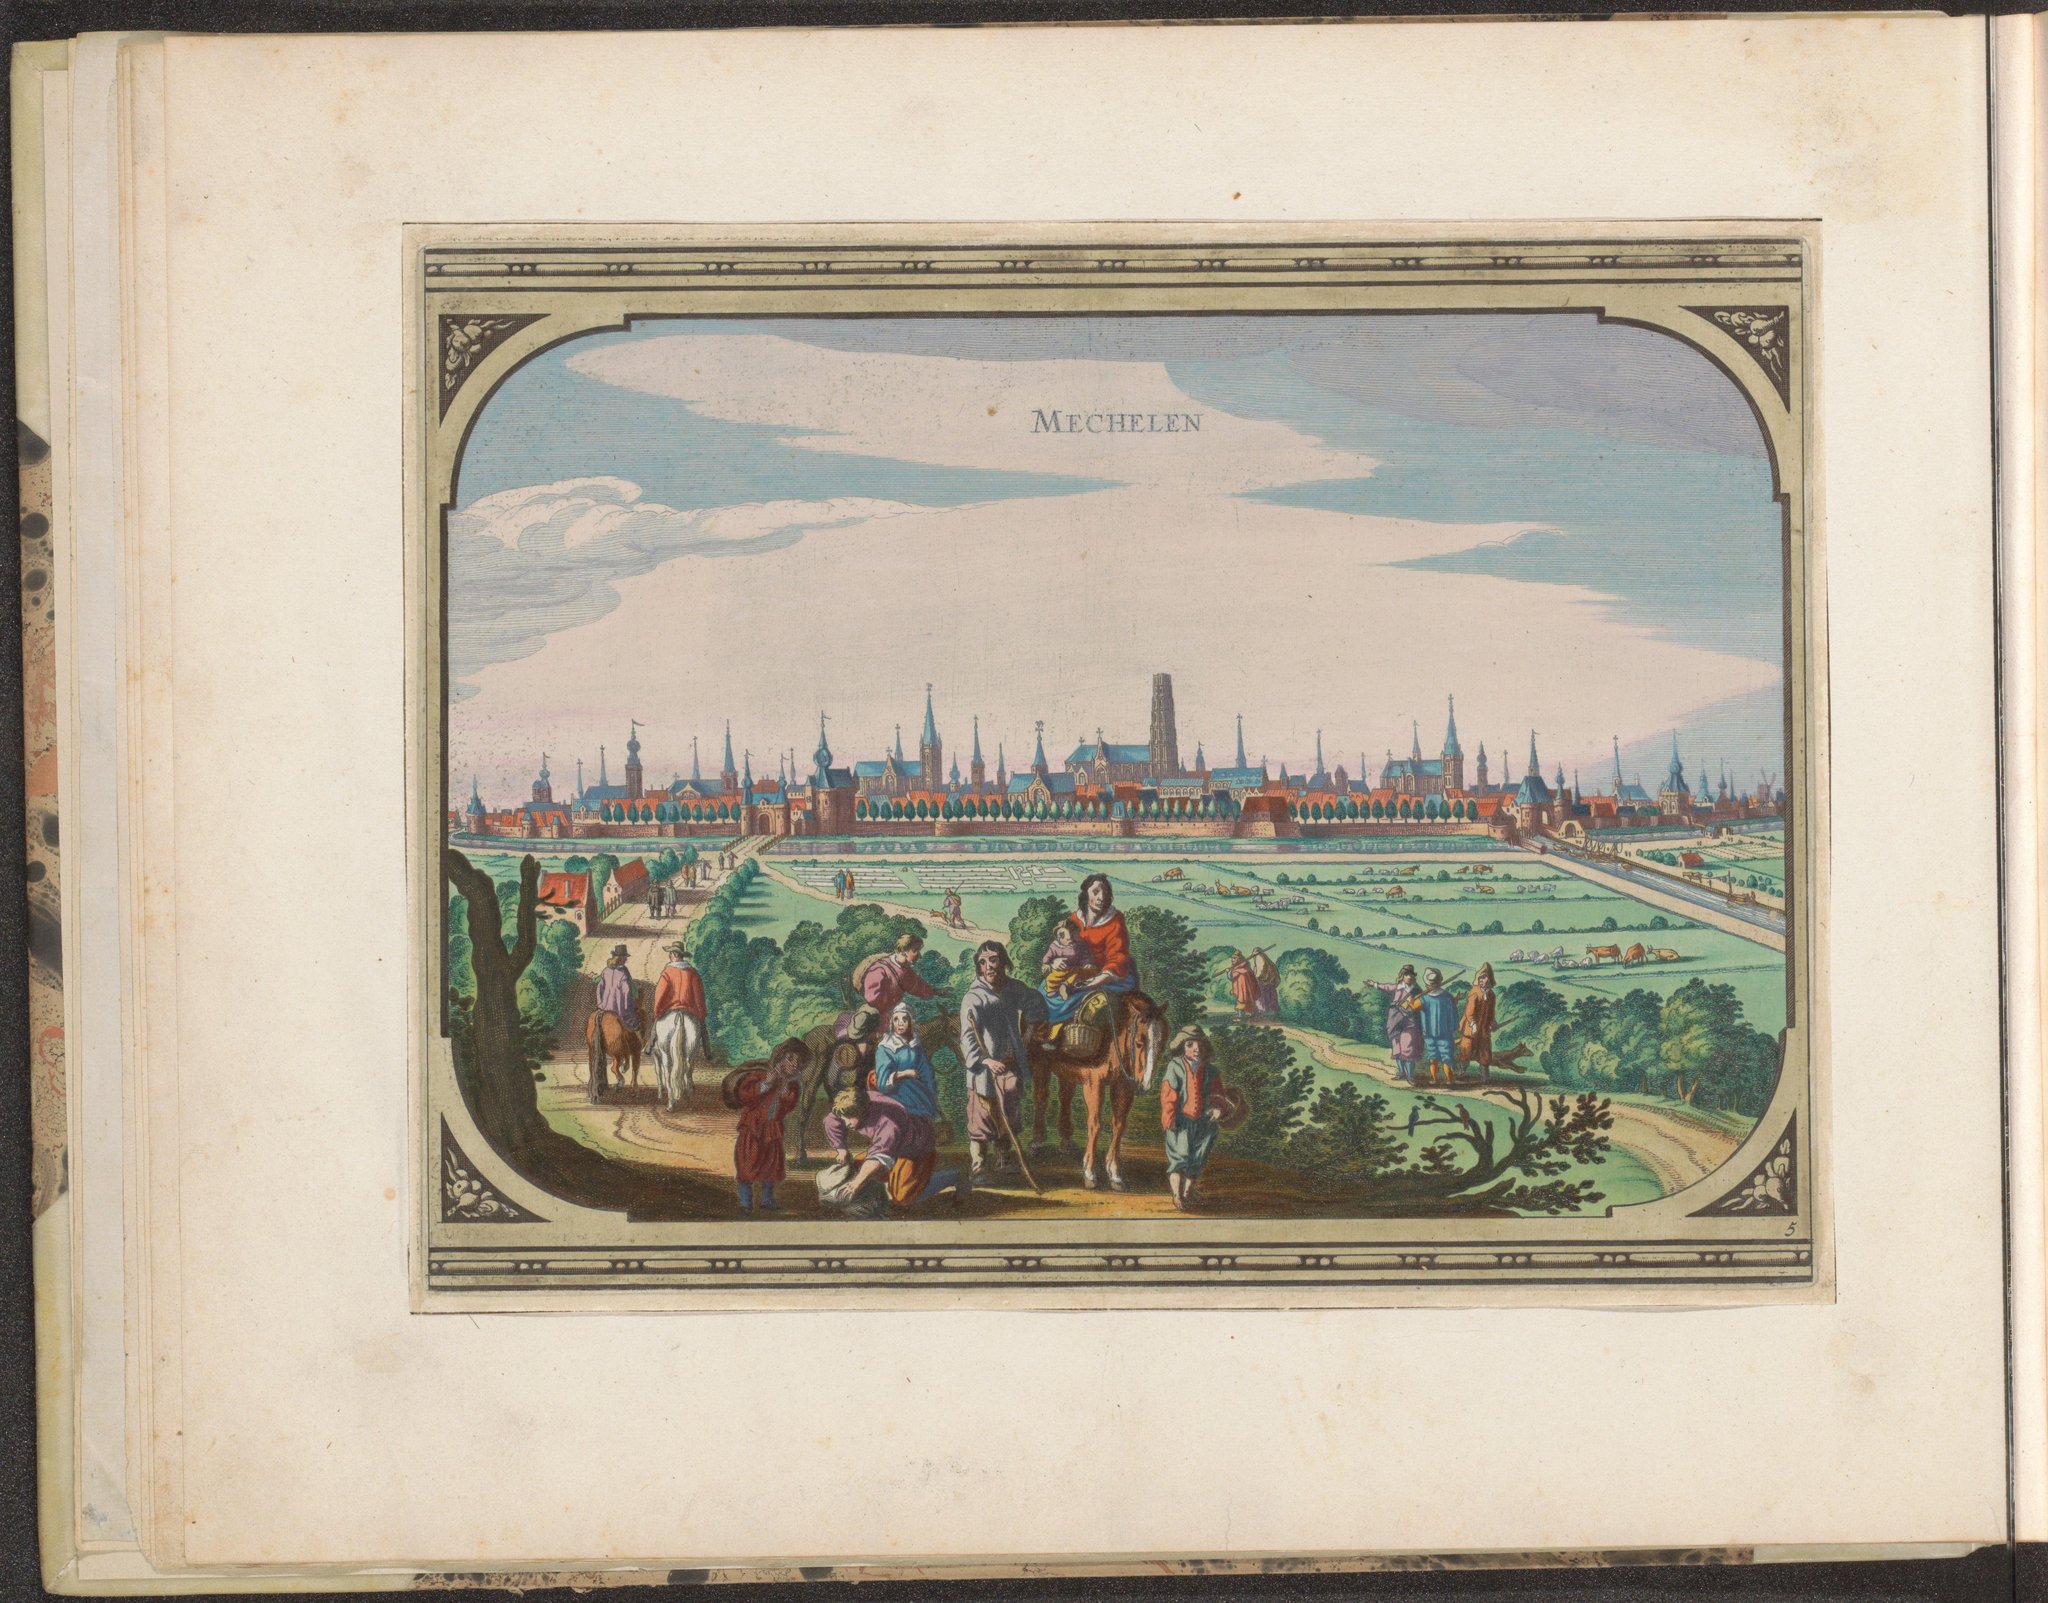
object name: album leaf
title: Gezicht op Mechelen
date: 1657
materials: paper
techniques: etching, hand coloring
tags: riding a horse, ass, or mule; rider, horseman, city-view, and landscape with man-made constructions, 'en route', traveller under way, mechelen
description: Gezicht op de stad Mechelen. Twee wegen leiden naar de stad. Op de voorgrond onder meer een vrouw met kind op een paard. Haar man staat ernaast. Ze wachten op een jongen die op zijn knieën zijn spullen inpakt. De prent maakt deel uit van een album.